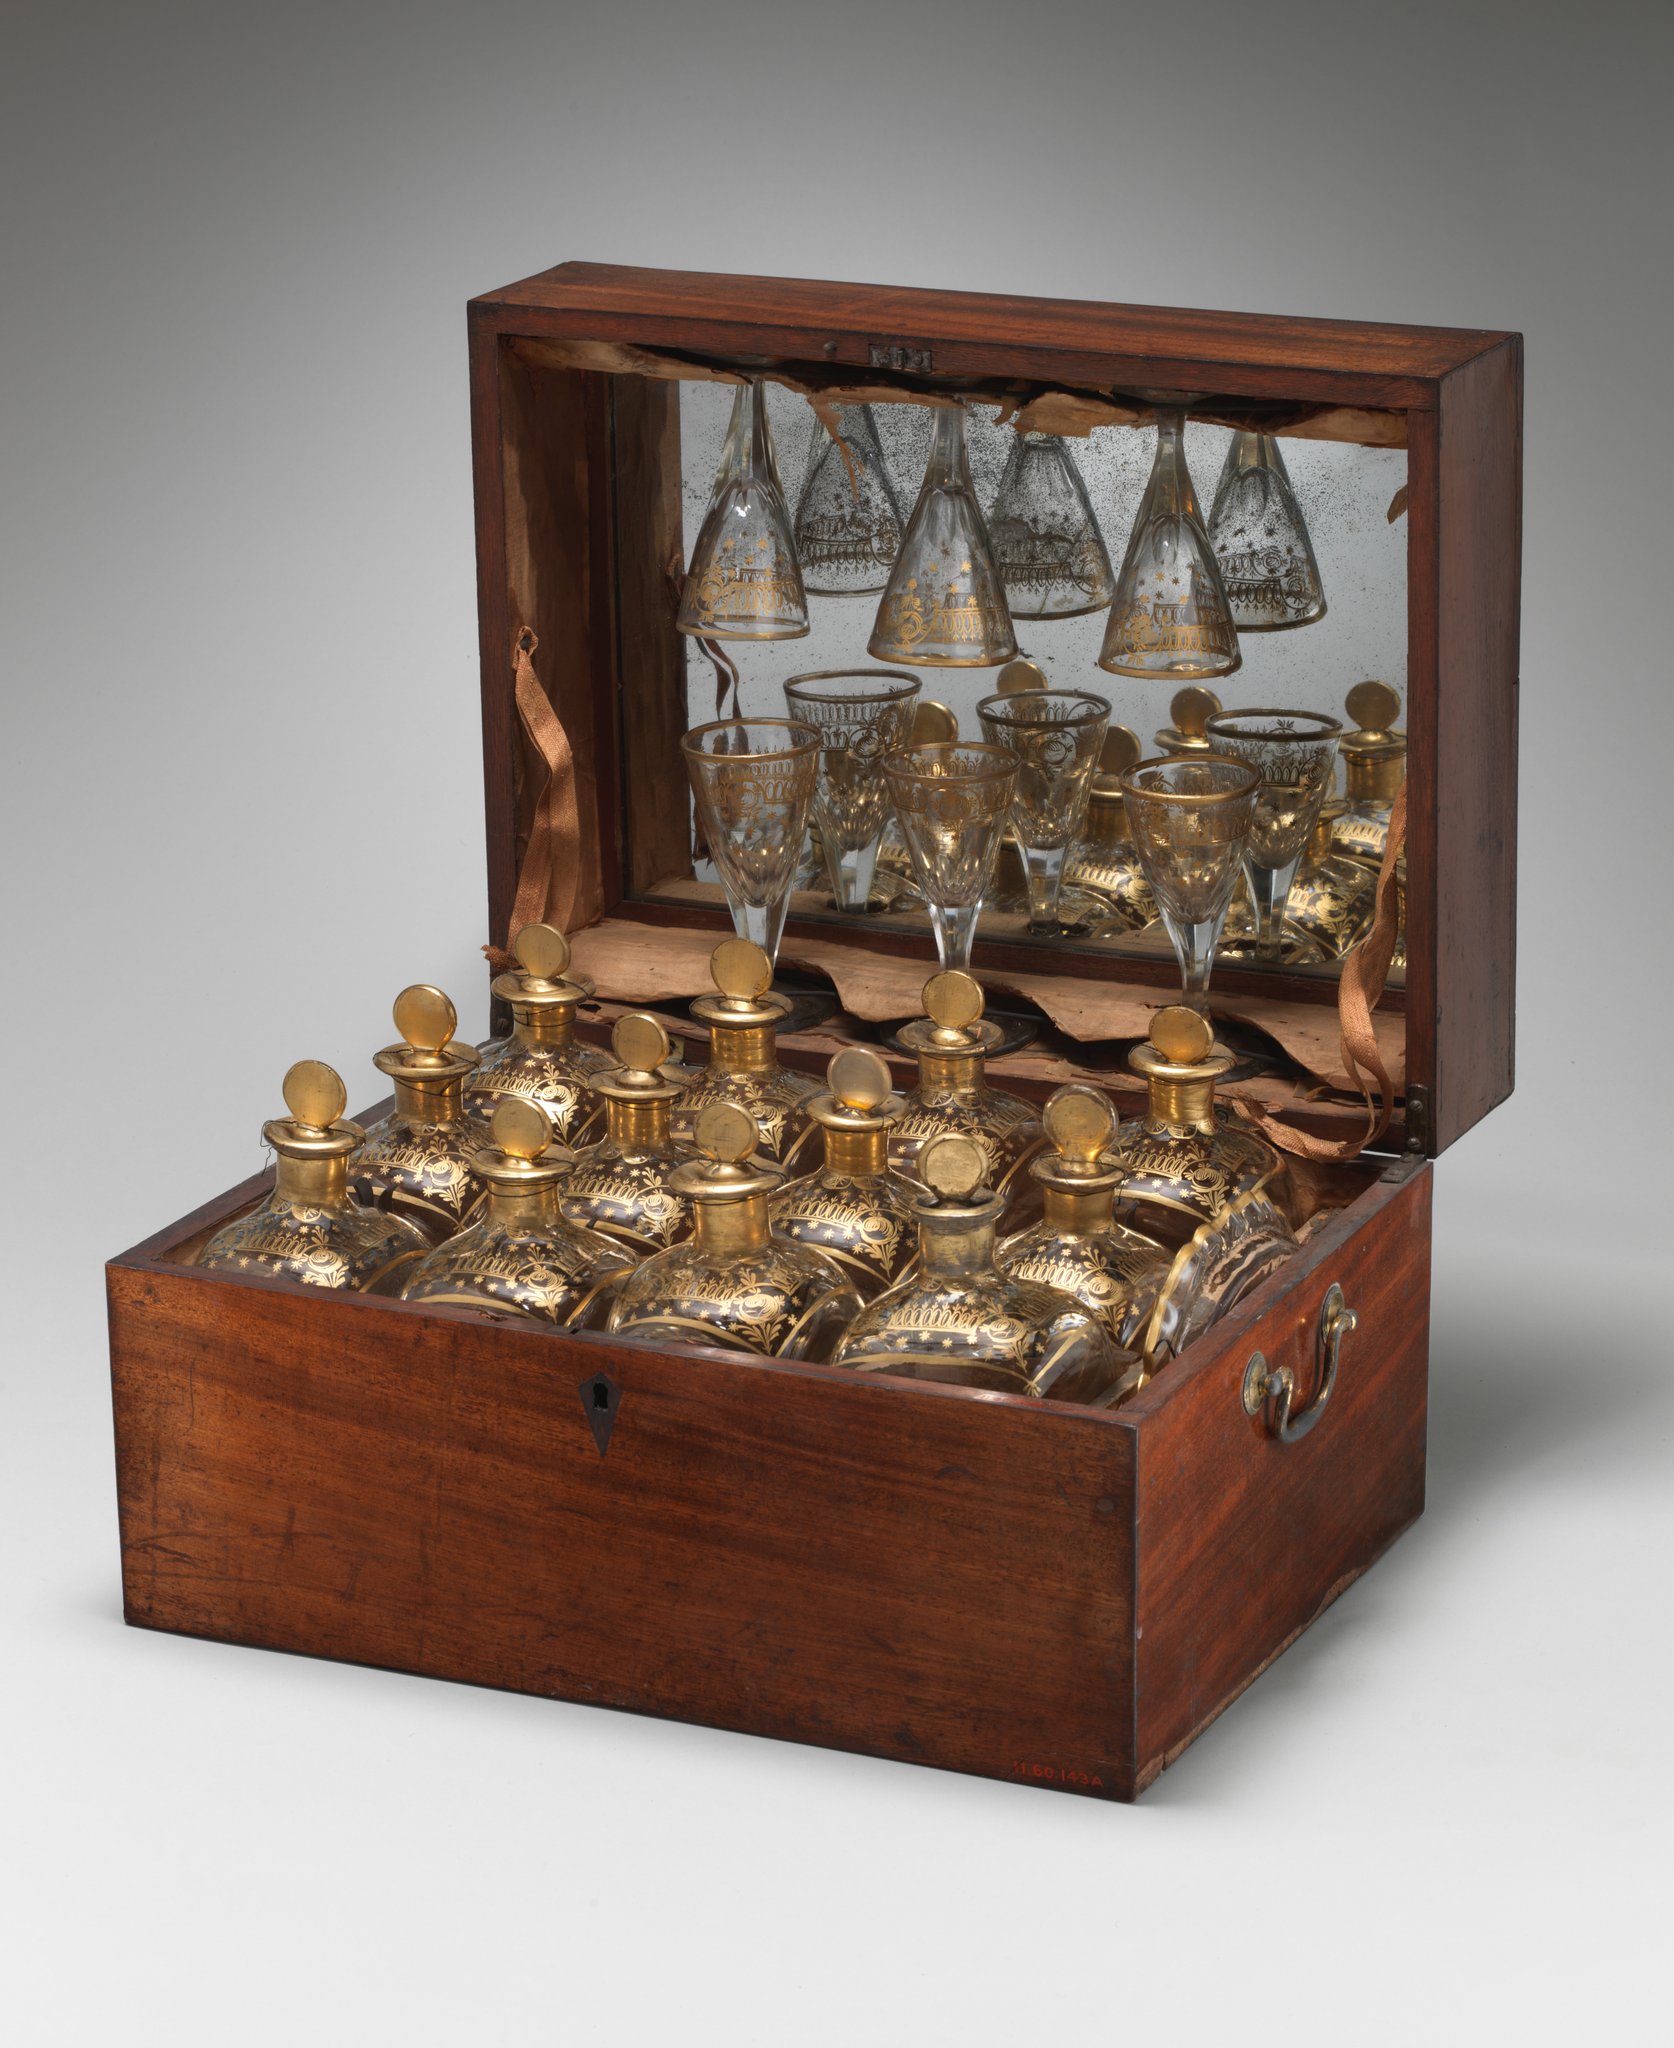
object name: canteen with bottle, glass and dish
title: Canteen with twelve bottles, six glasses and one dish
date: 1767-1800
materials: brass, glass, wood